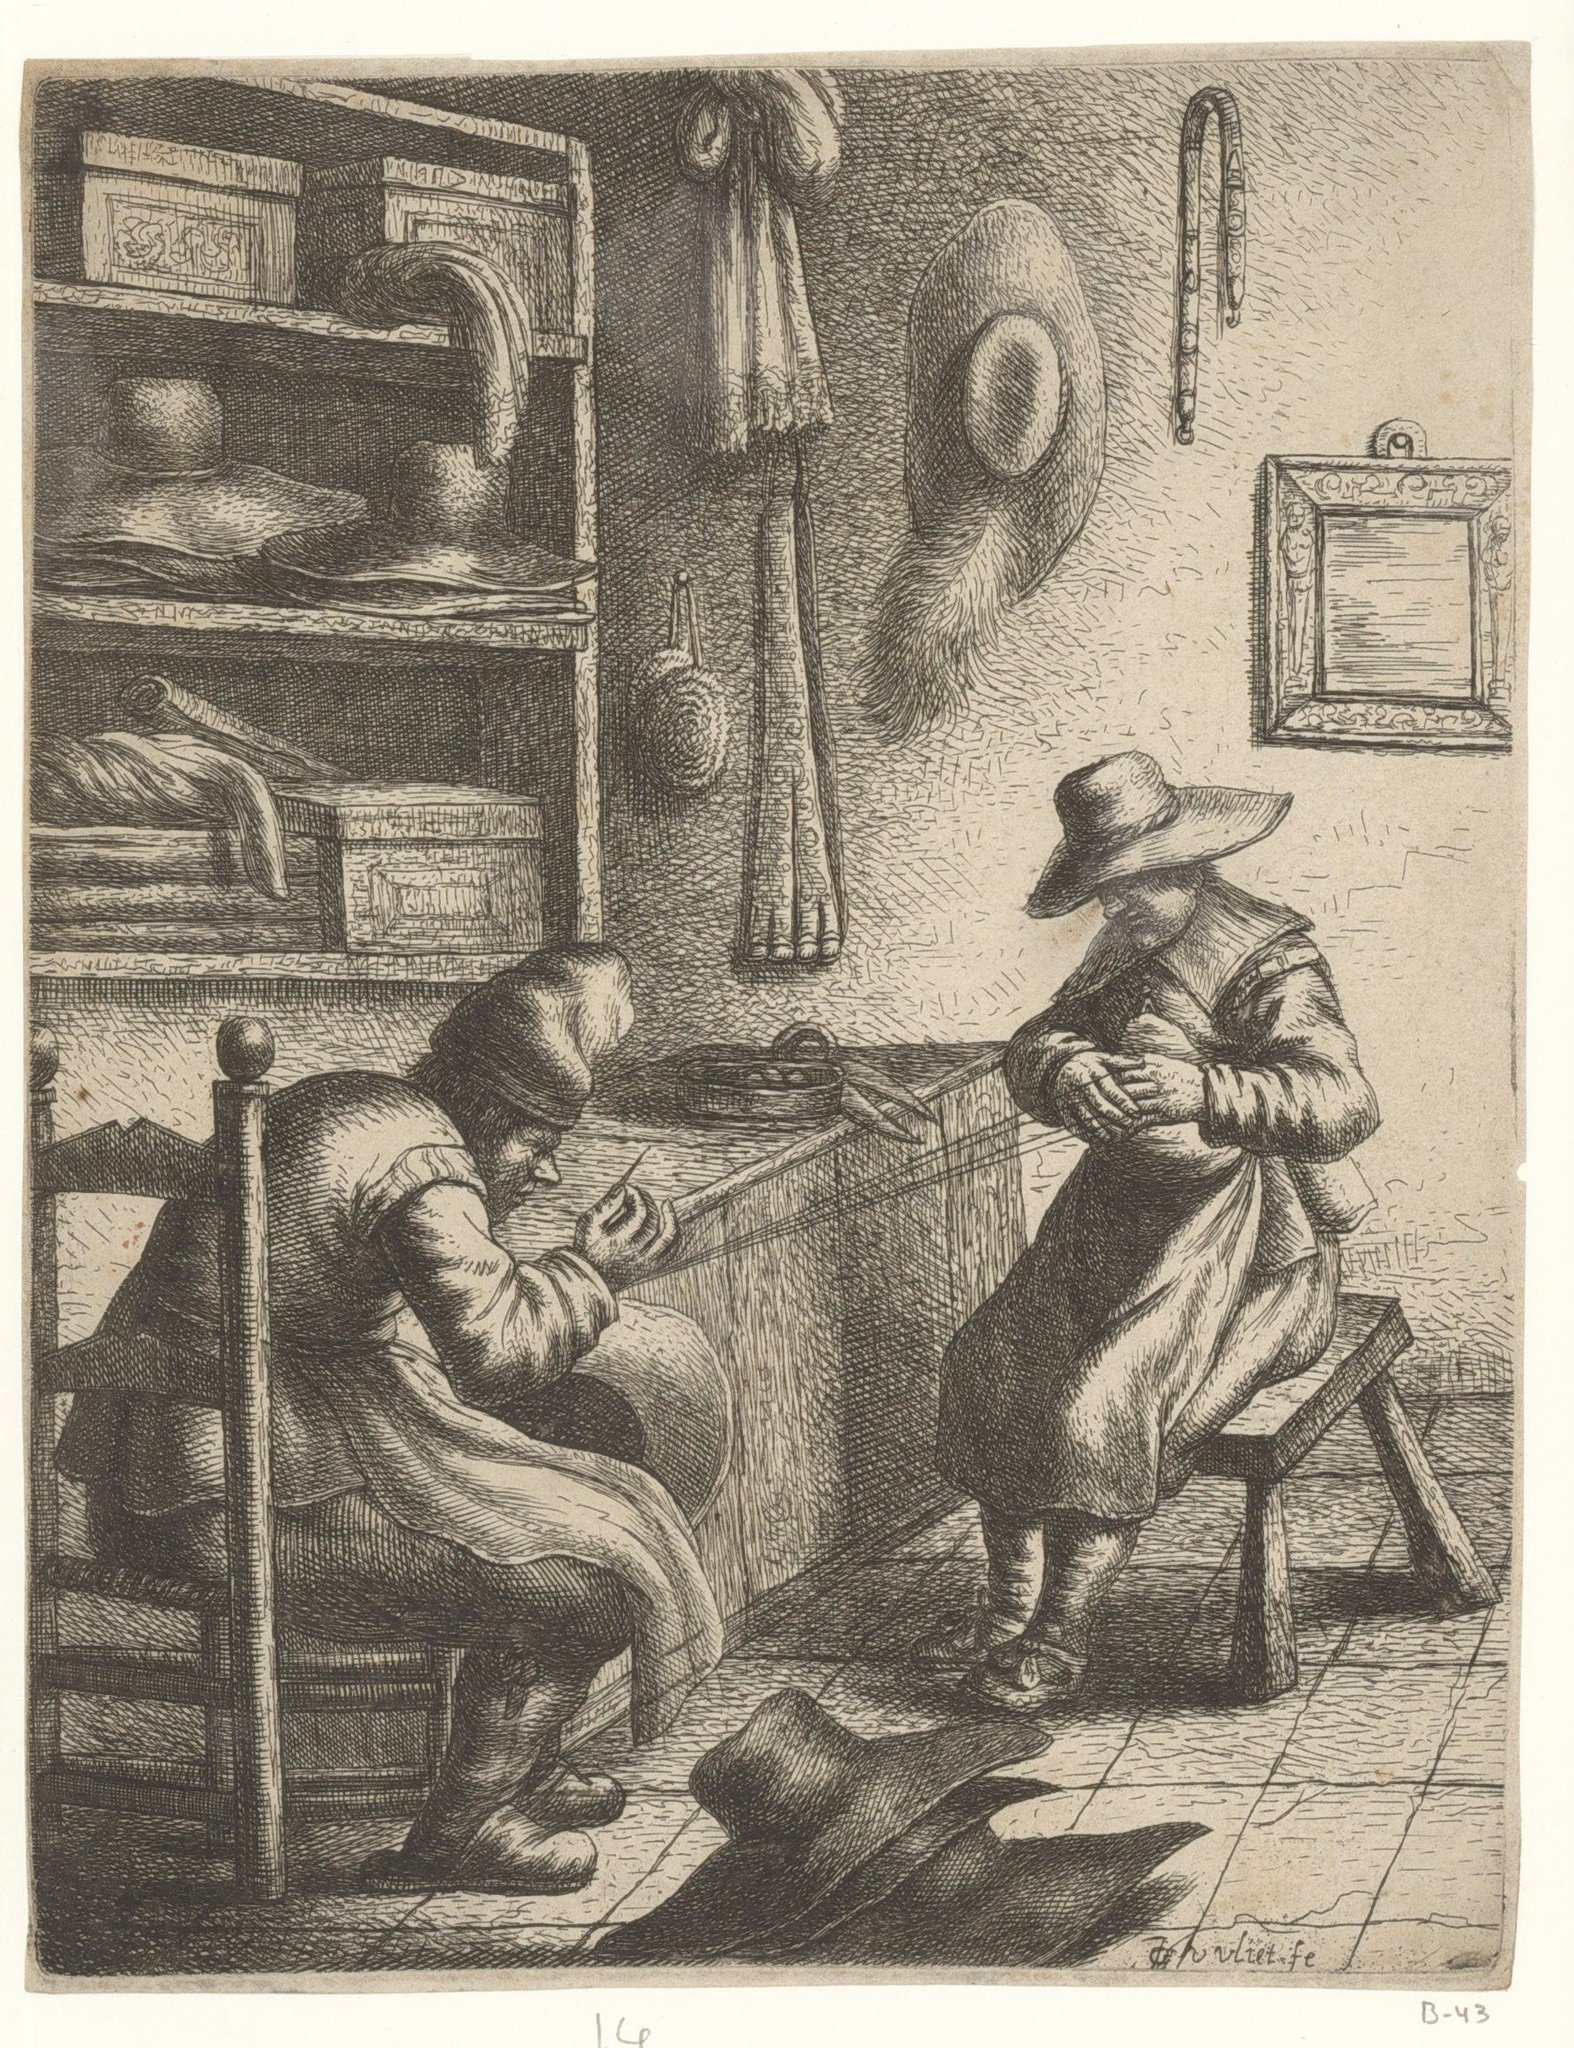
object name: print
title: Hoedenmaker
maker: jan gillisz. van vliet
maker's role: draughtsman, painter, print maker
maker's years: 1600-1668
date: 1635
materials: paper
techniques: etching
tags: handicrafts, craftsman at work, mirror, head-gear: hat (+ men's clothes), hatter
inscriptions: stamp, collector's mark: Lugt 1641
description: Onderwerpsrubrieken binnen de Atlas Zeden en Gewoonten: Handel, Nijverheid en Verkeer, Beroep en bedrijf, Complete suites.